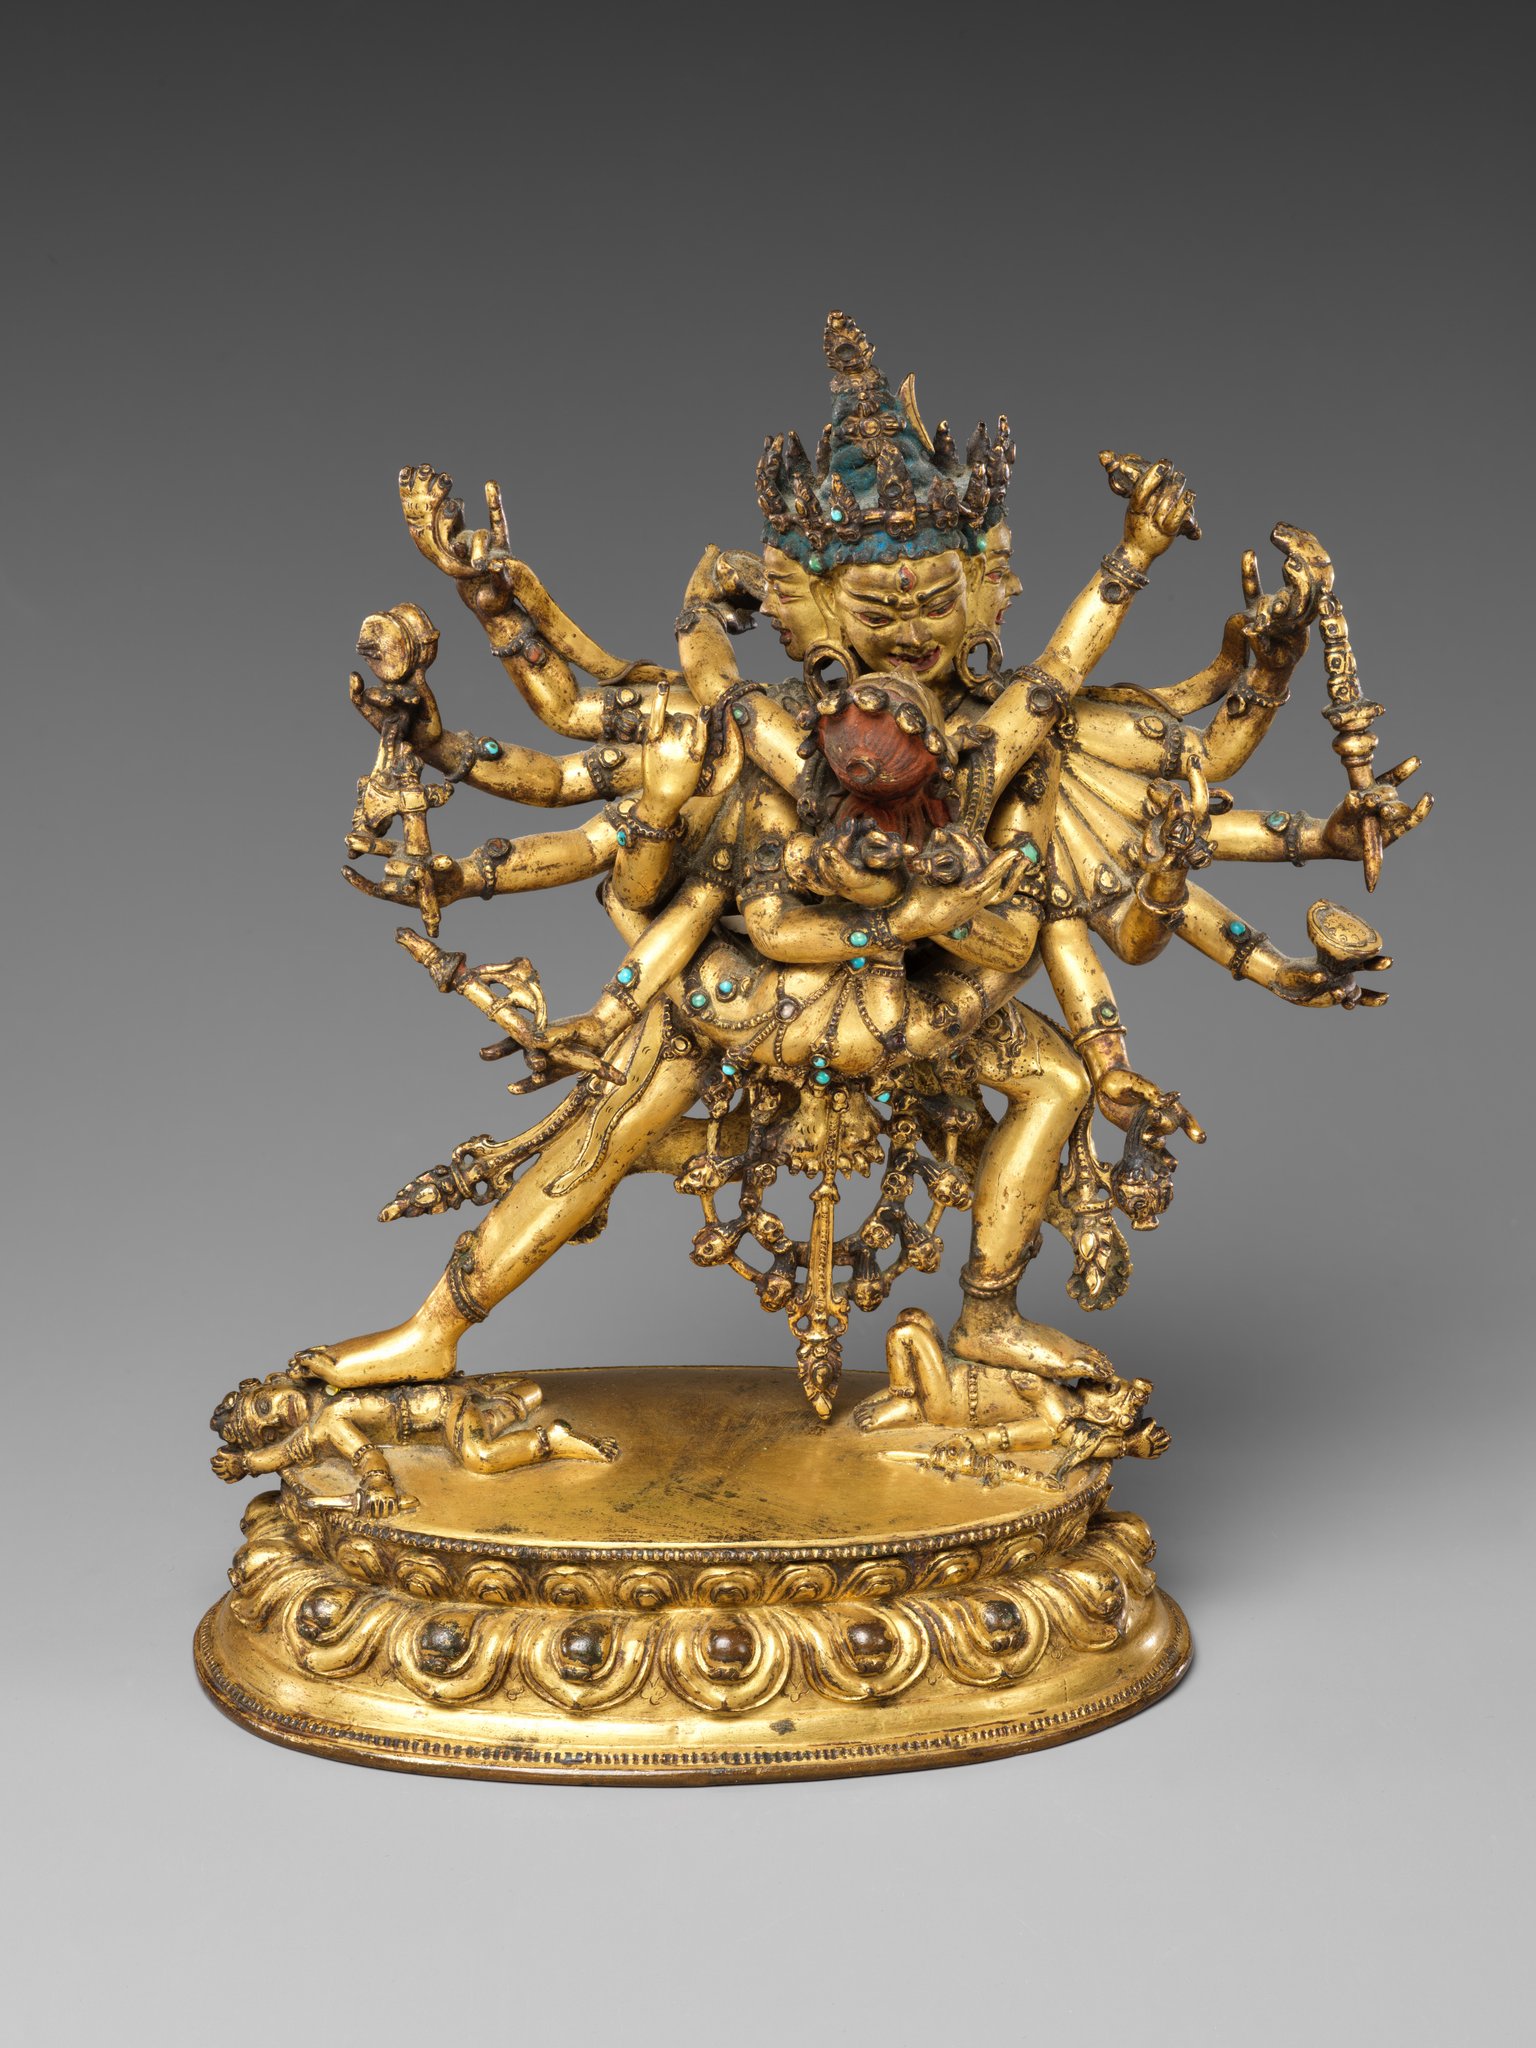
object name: figure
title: Chakrasamvara and Vajravarahi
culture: tibetan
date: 1467-1600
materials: gilt bronze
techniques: inlay